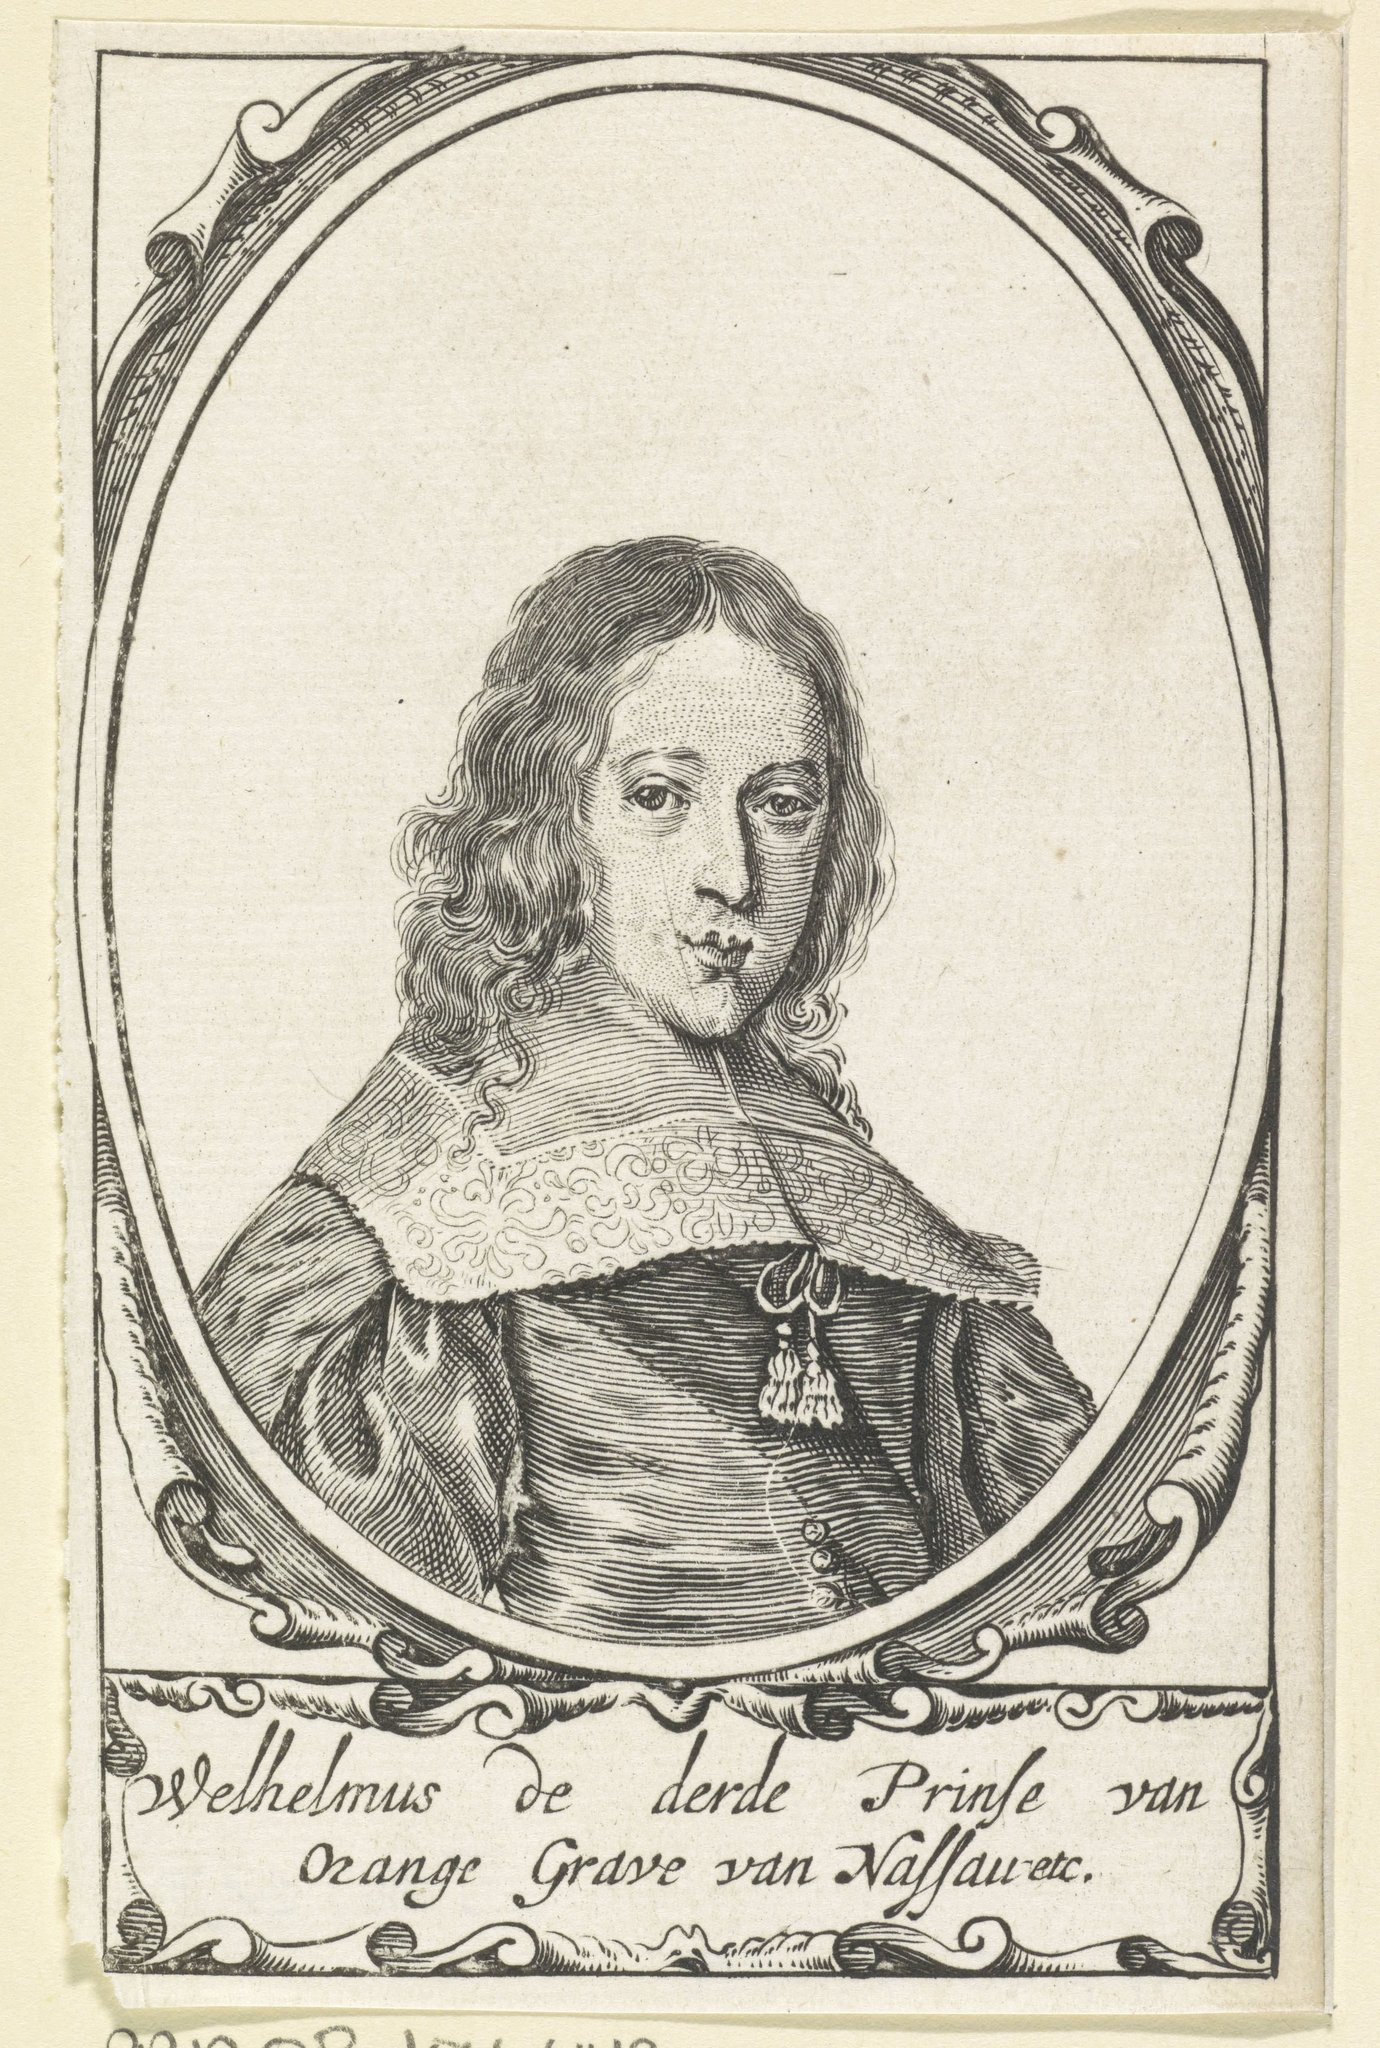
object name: print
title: Portret van Willem III, prins van Oranje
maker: Anonymous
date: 1660-1749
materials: paper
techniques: engraving, etching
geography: low countries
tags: the hague, william iii (prince of orange and king of england, scotland, and ireland)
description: De hier vermelde titel verwijst naar de hoogst verkregen titel van de geportretteerde, niet per se naar de titel die de geportretteerde op deze voorstelling draagt.